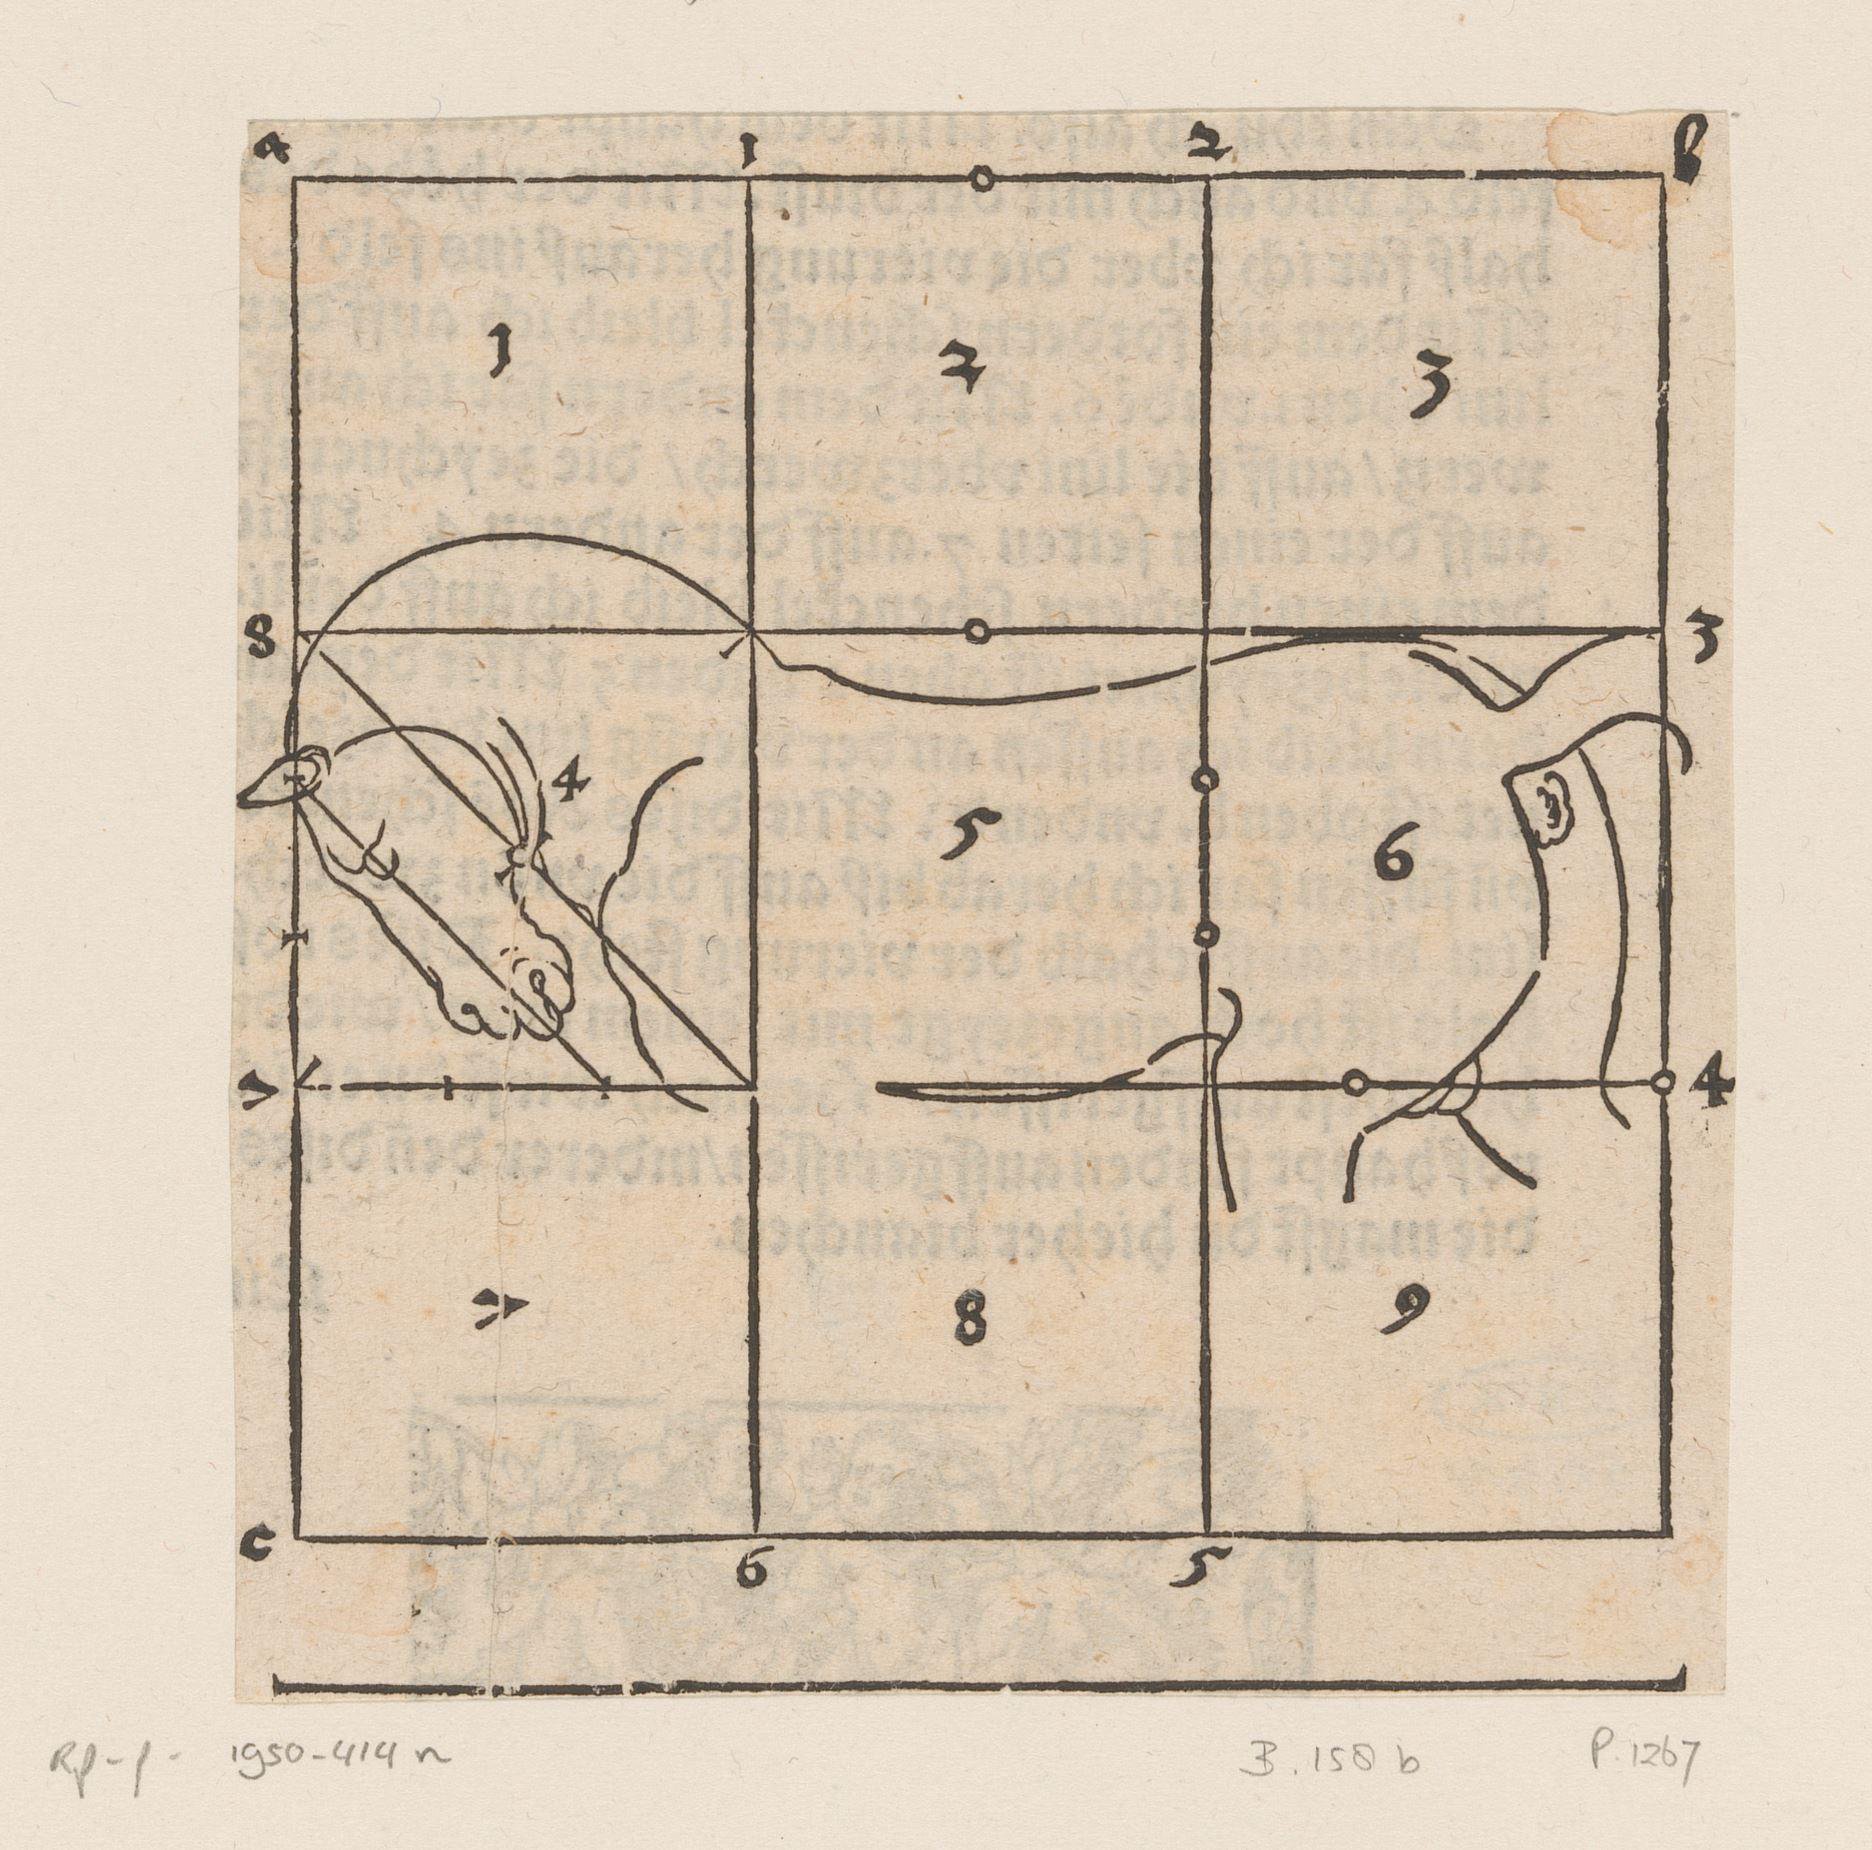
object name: book illustration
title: Model voor een paard met raster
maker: Anonymous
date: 1565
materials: paper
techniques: letterpress printing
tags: horses and kindred animals, model-books ~ implements of painter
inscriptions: collector's mark: Lugt 2228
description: Prent afkomstig uit: Beham, Hans Sebald. Sebalden Behems Kunst und Ler Büchlin (...). Frankfurt am Main: erven Christian Egenolff, 1565.